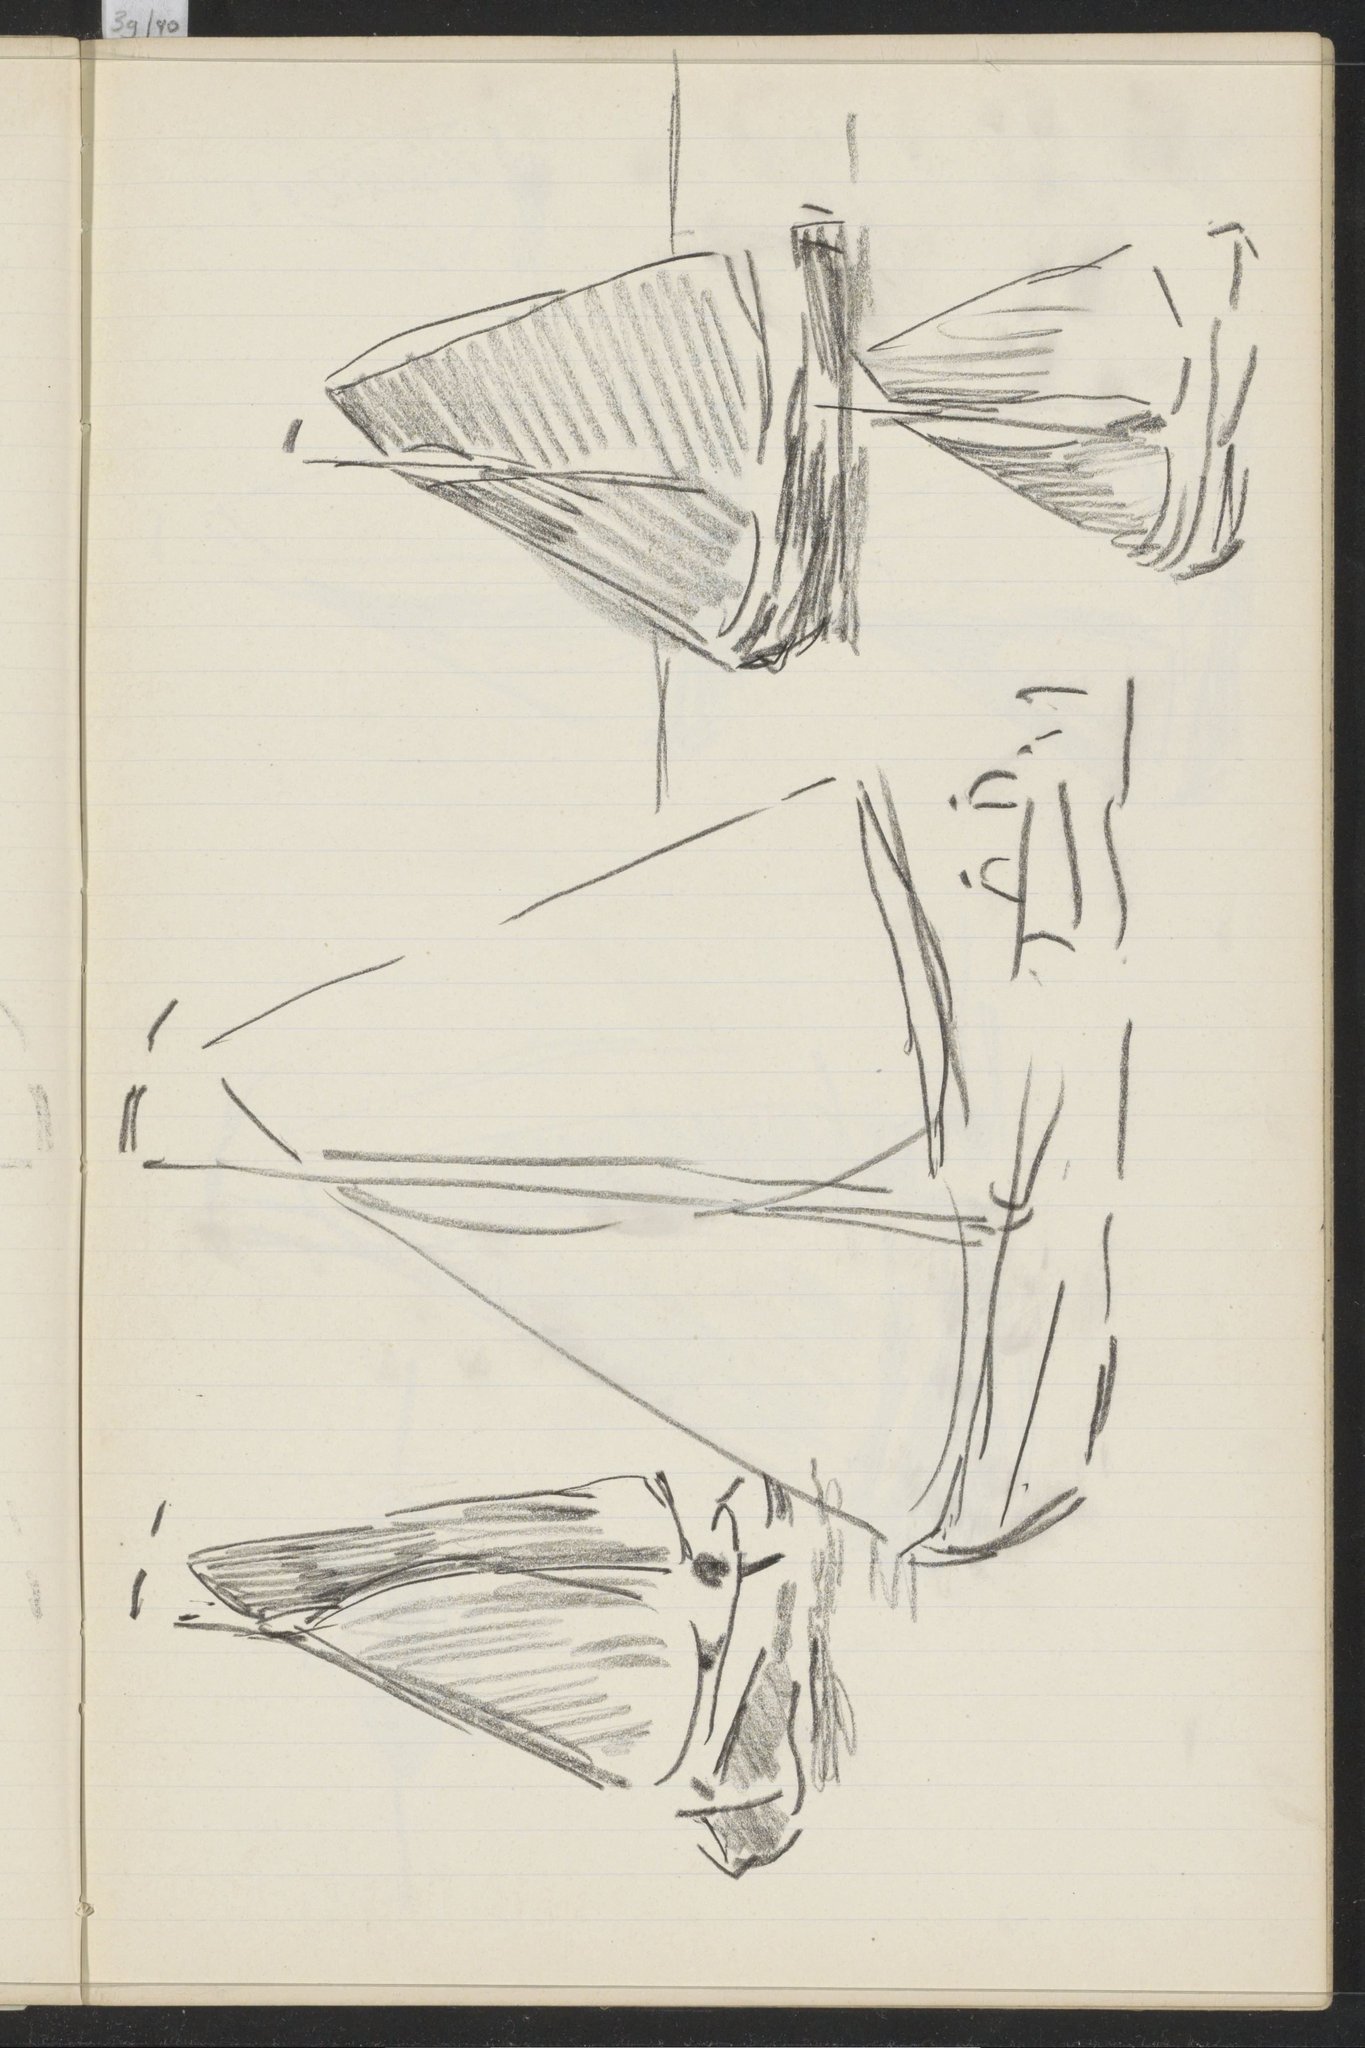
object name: sketchbook leaf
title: Zeilschepen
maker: willem bastiaan tholen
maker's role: draughtsman, painter, print maker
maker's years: 1860-1931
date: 1900-1931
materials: chalk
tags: sailing-ship, sailing-boat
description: Blad 35 recto uit een schetsboek met 55 bladen.